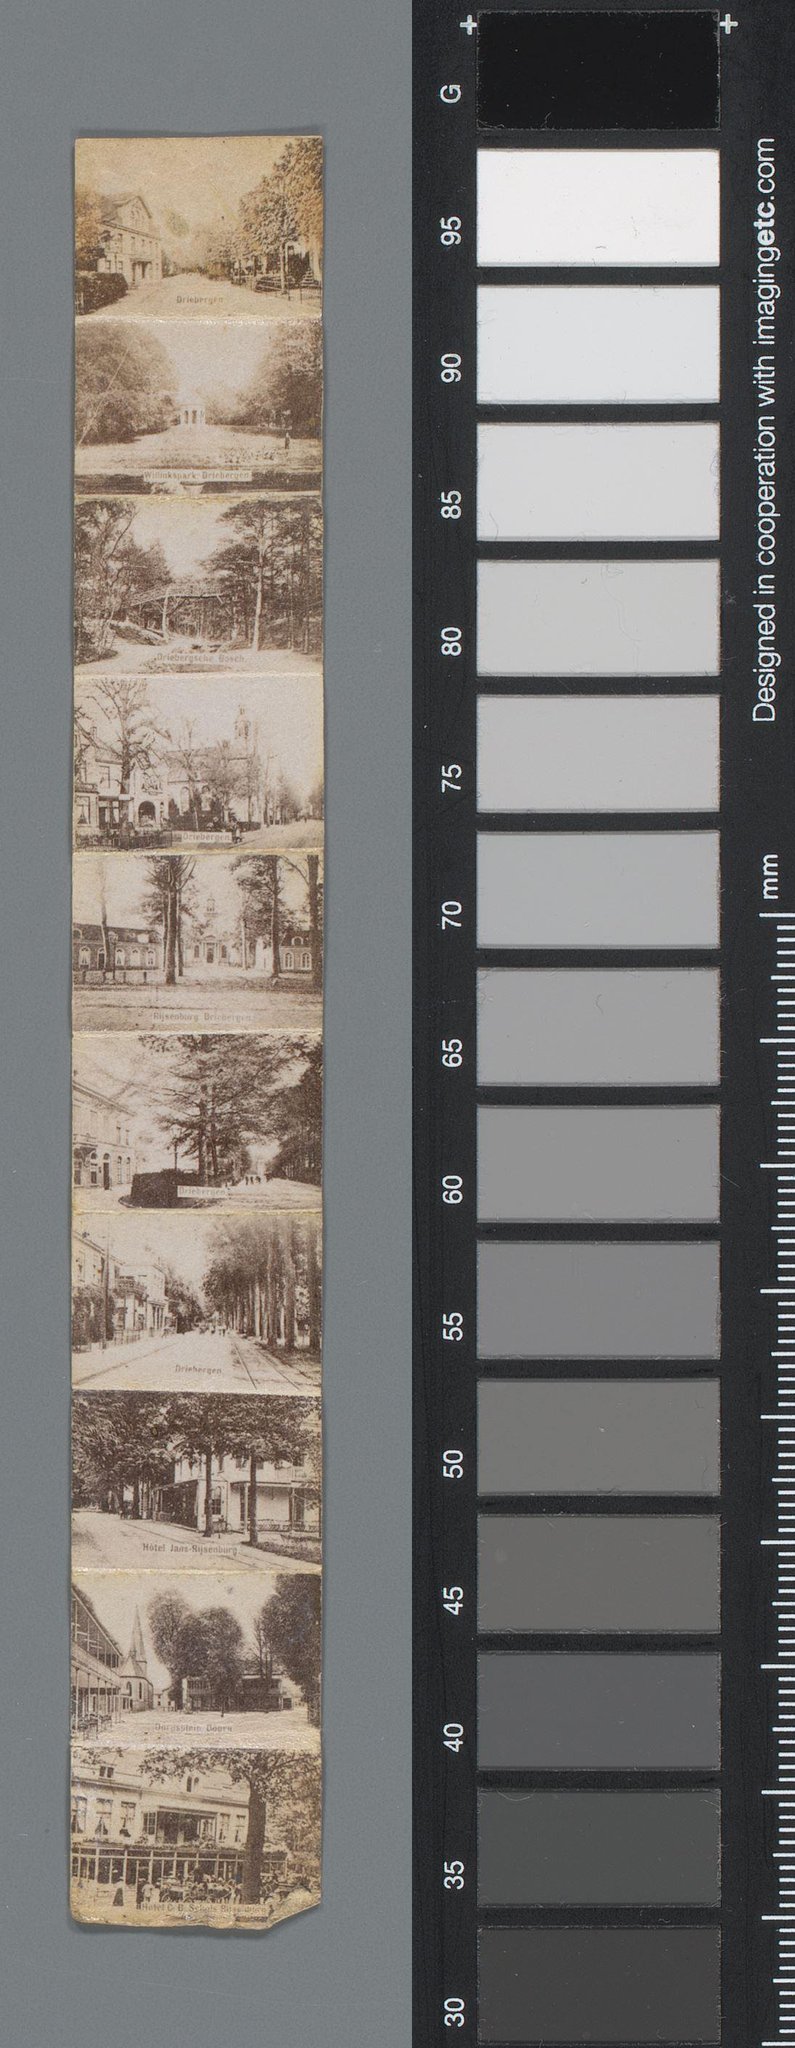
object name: album leaf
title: Gezicht op een folly in Beerschoten-Willinkshof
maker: Anonymous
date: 1851-1900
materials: paper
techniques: albumen print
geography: beerschoten-willinkshof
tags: architectural folly